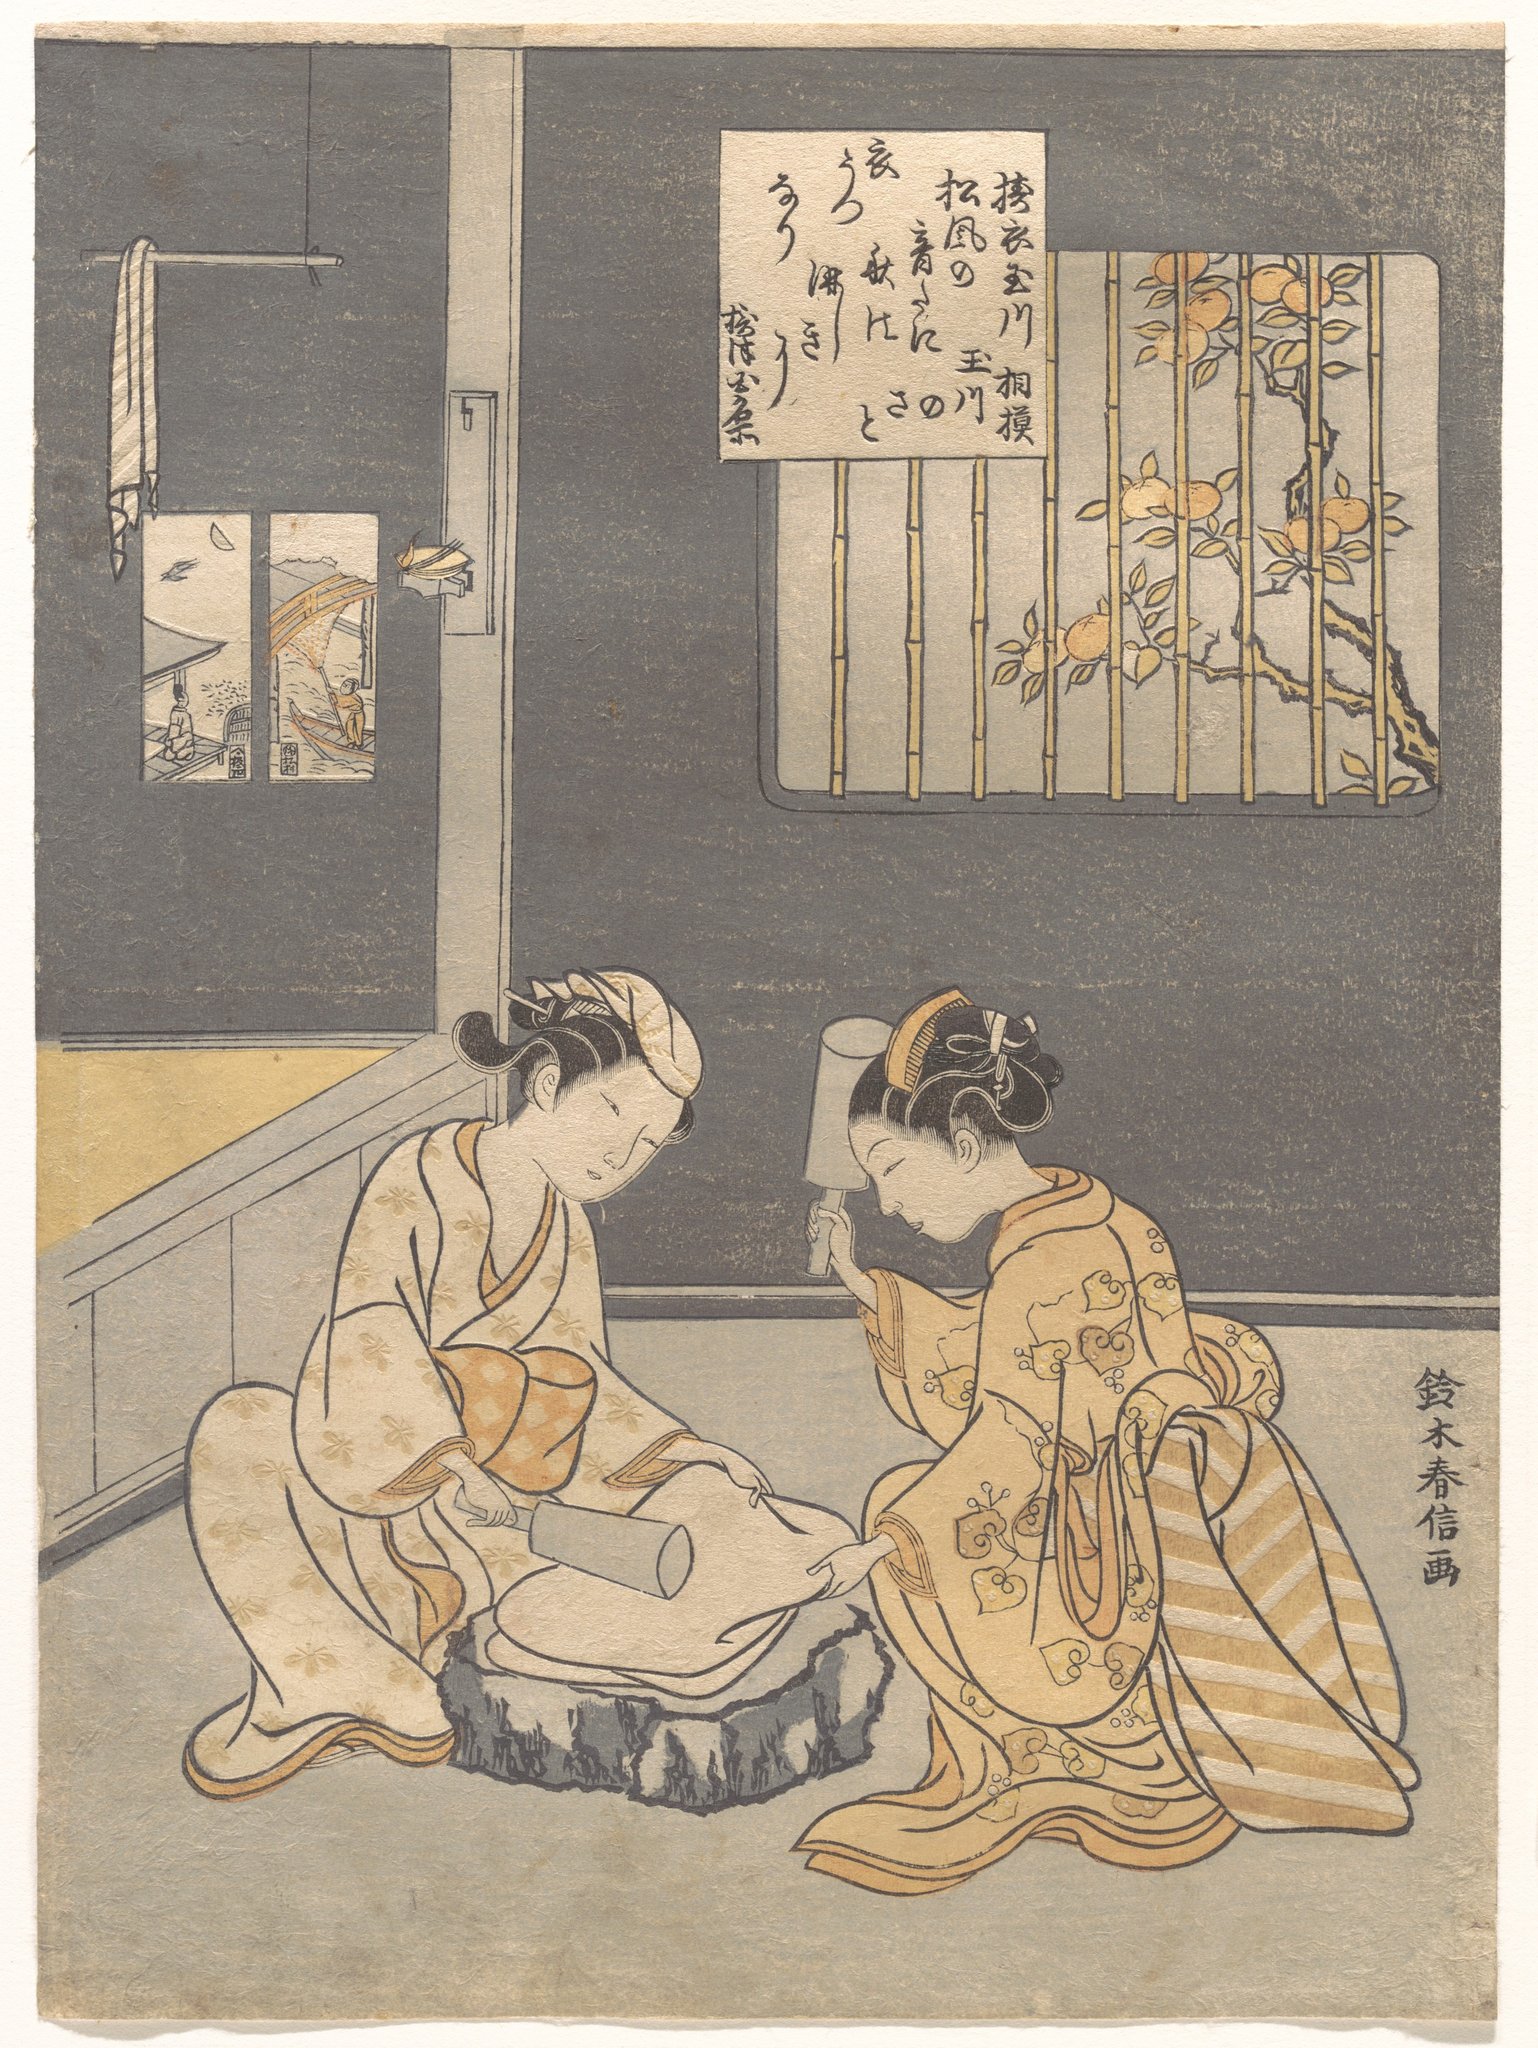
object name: woodblock print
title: The Cloth-Fulling Jewel River, a Famous Place in Settsu Province (Tōi no Tamagawa, Settsu no meisho), from an untitled series of Six Jewel Rivers (Mu Tamagawa)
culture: japanese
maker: suzuki harunobu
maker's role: artist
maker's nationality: japanese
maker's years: 1725-1770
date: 1766-1767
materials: ink, paper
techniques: nishiki e, woodblock print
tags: women,working